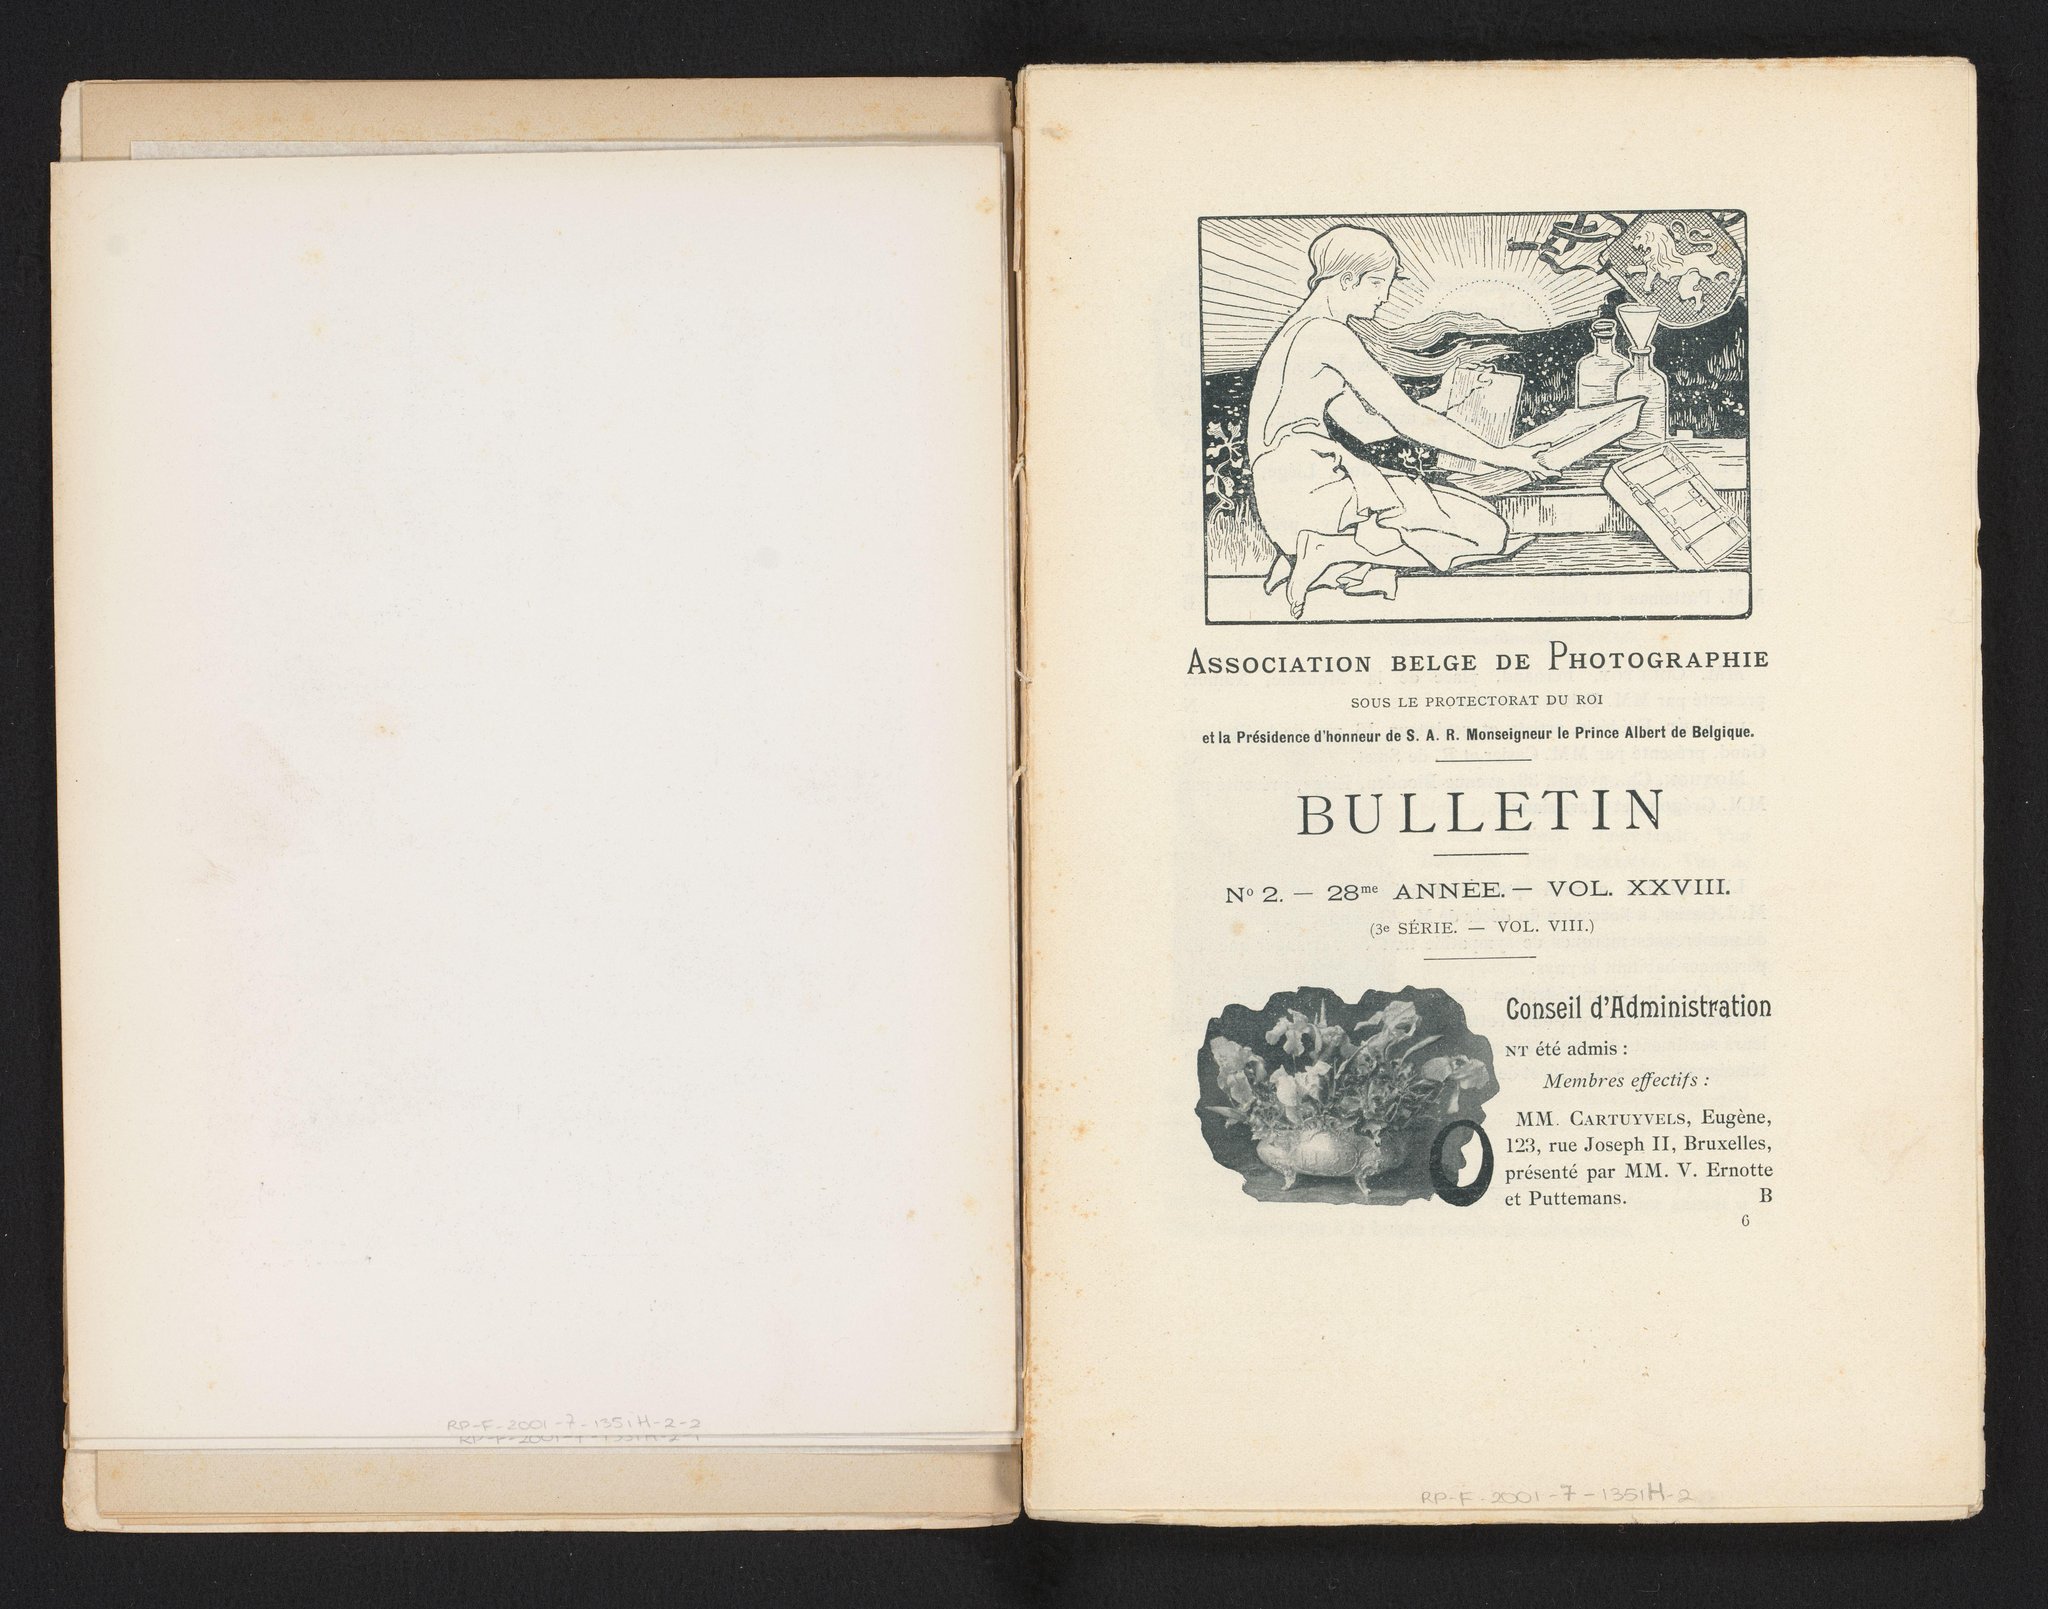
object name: book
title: Bulletin / Association belge de photographie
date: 1901-1902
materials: paper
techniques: photograph, printing, engraving